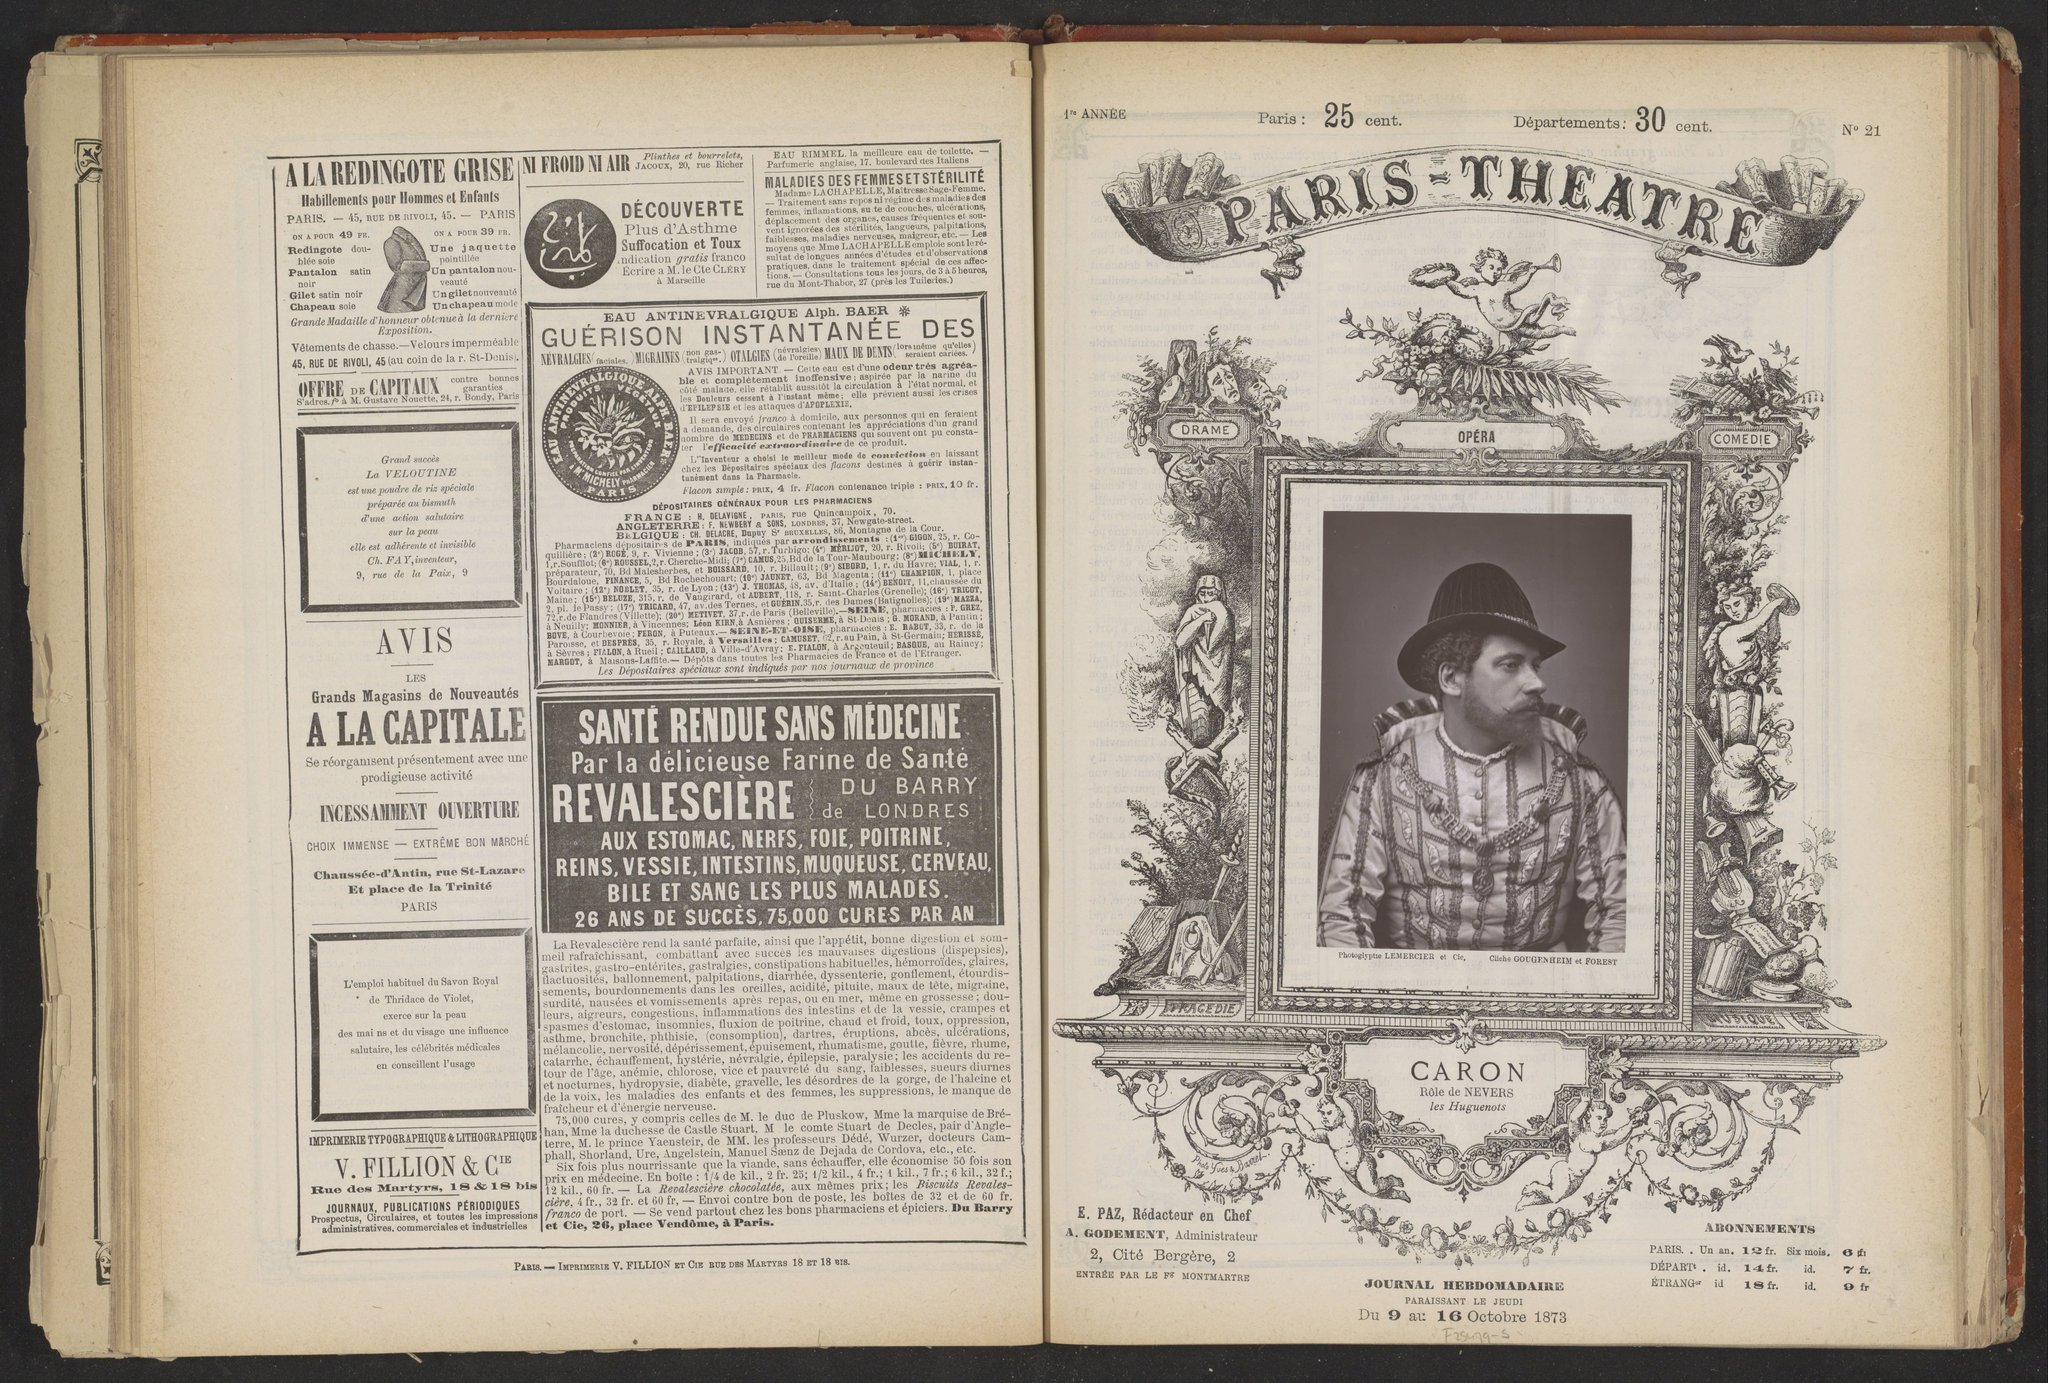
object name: page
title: Caron Rôle de Nevers les Huguenots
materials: paper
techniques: woodburytype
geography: france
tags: portrait of opera-singer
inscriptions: inscription: ‘Journal hebdomadaire paraissant le jeudi Du 9 au 16 Octobre 1873’, number: ‘No 21’